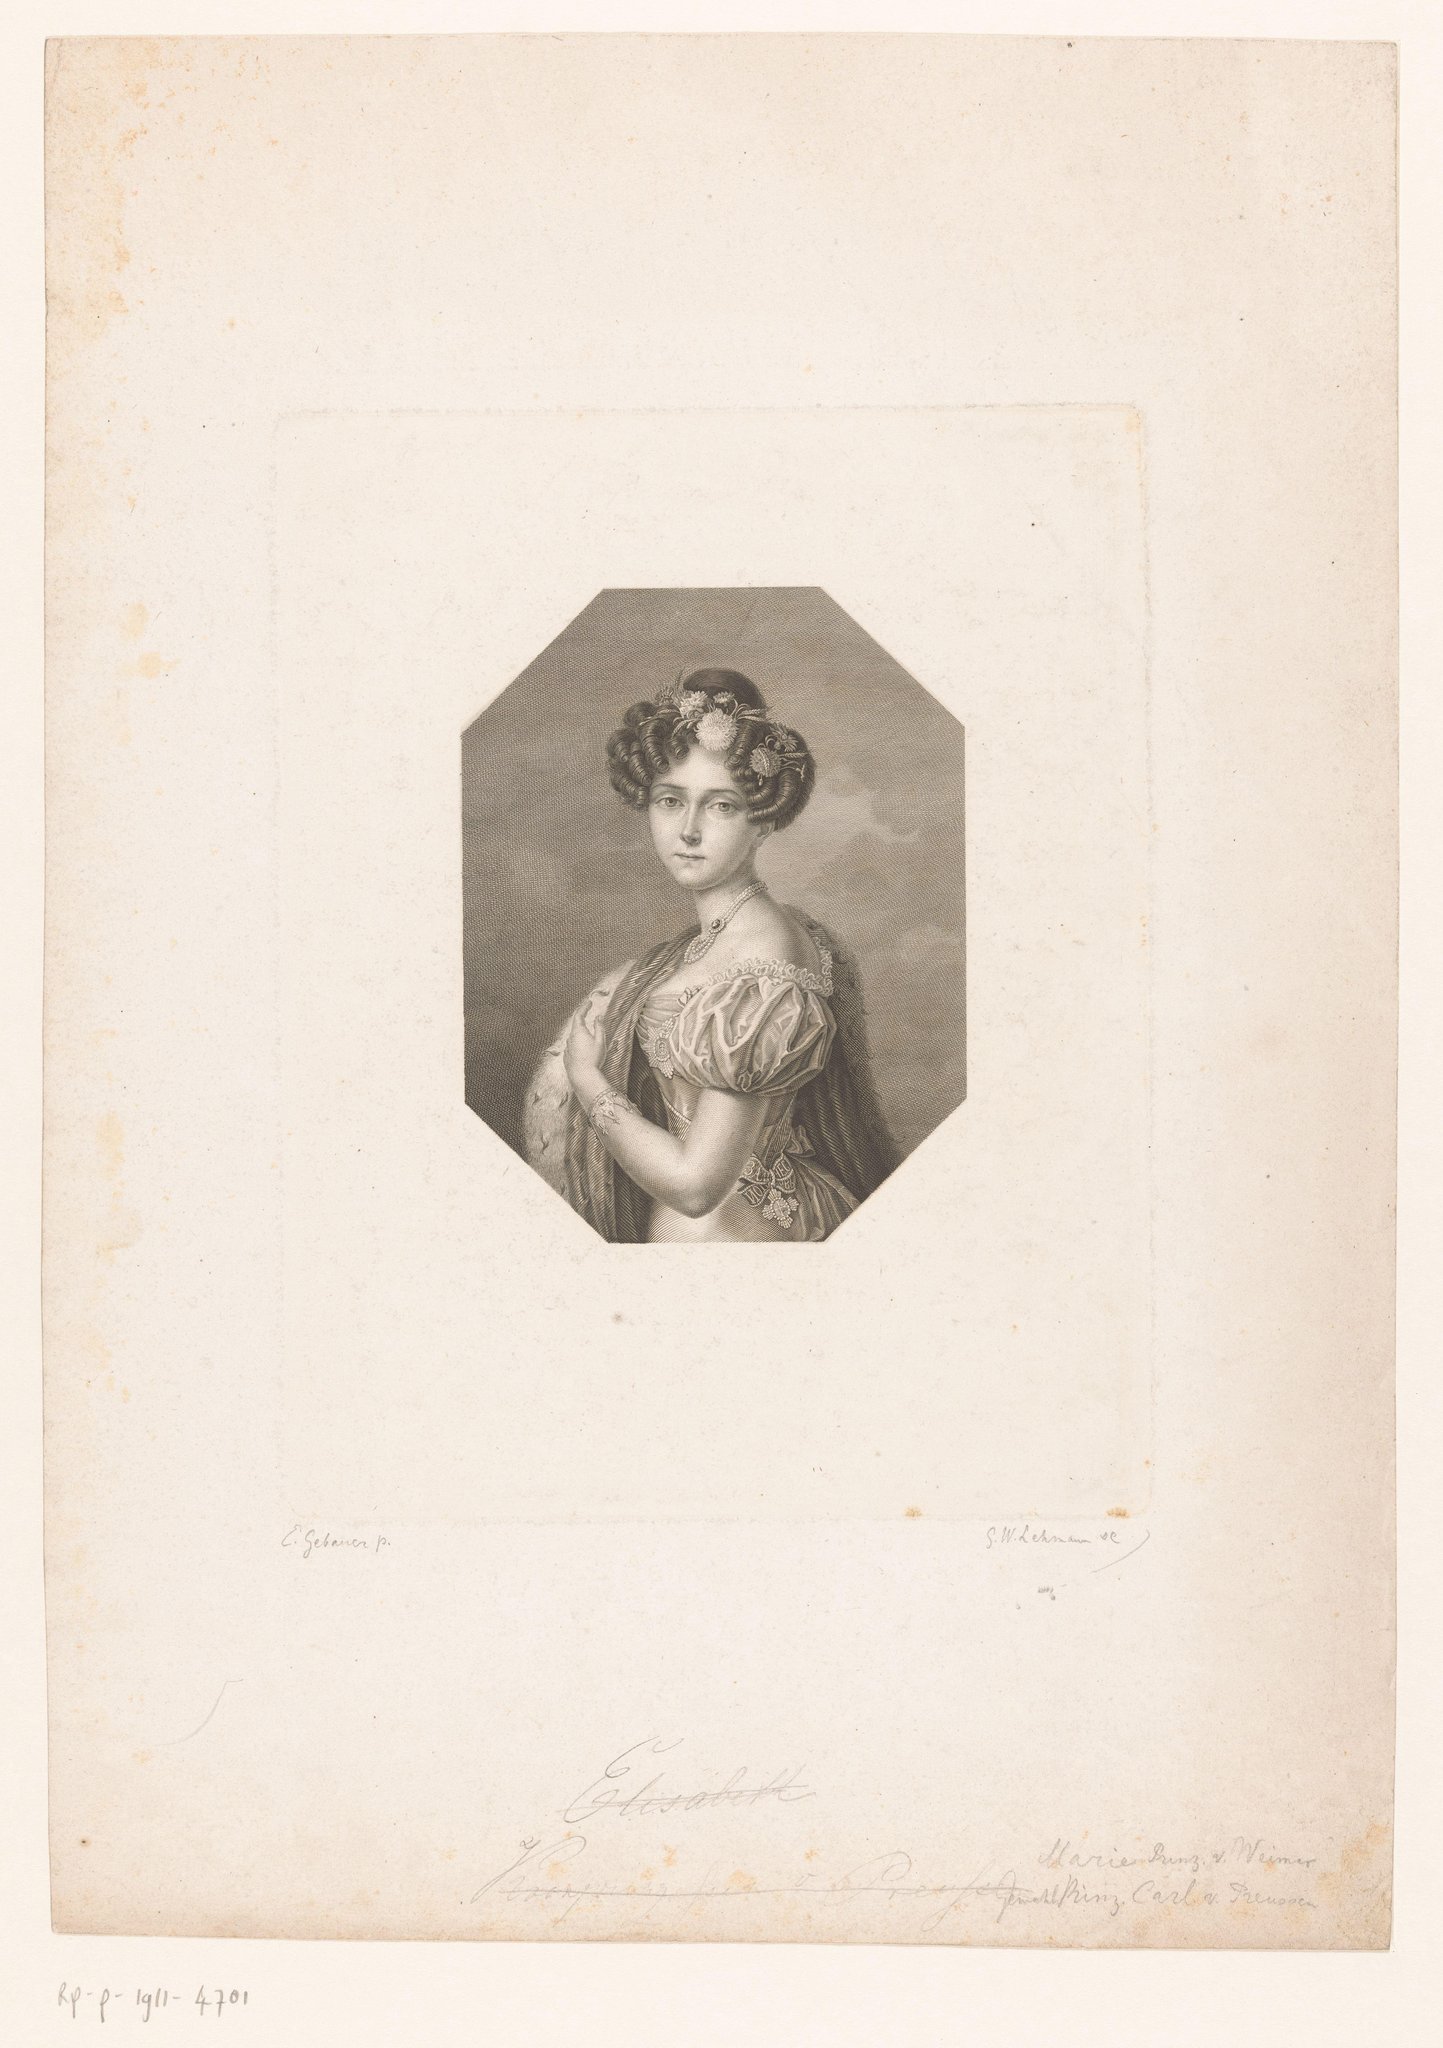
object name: print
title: Portret van Marie, prinses van Pruisen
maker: g.w. lehmann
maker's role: print maker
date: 1827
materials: paper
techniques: engraving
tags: berlin, historical persons - bb - woman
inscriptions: collector's mark: Lugt 2228